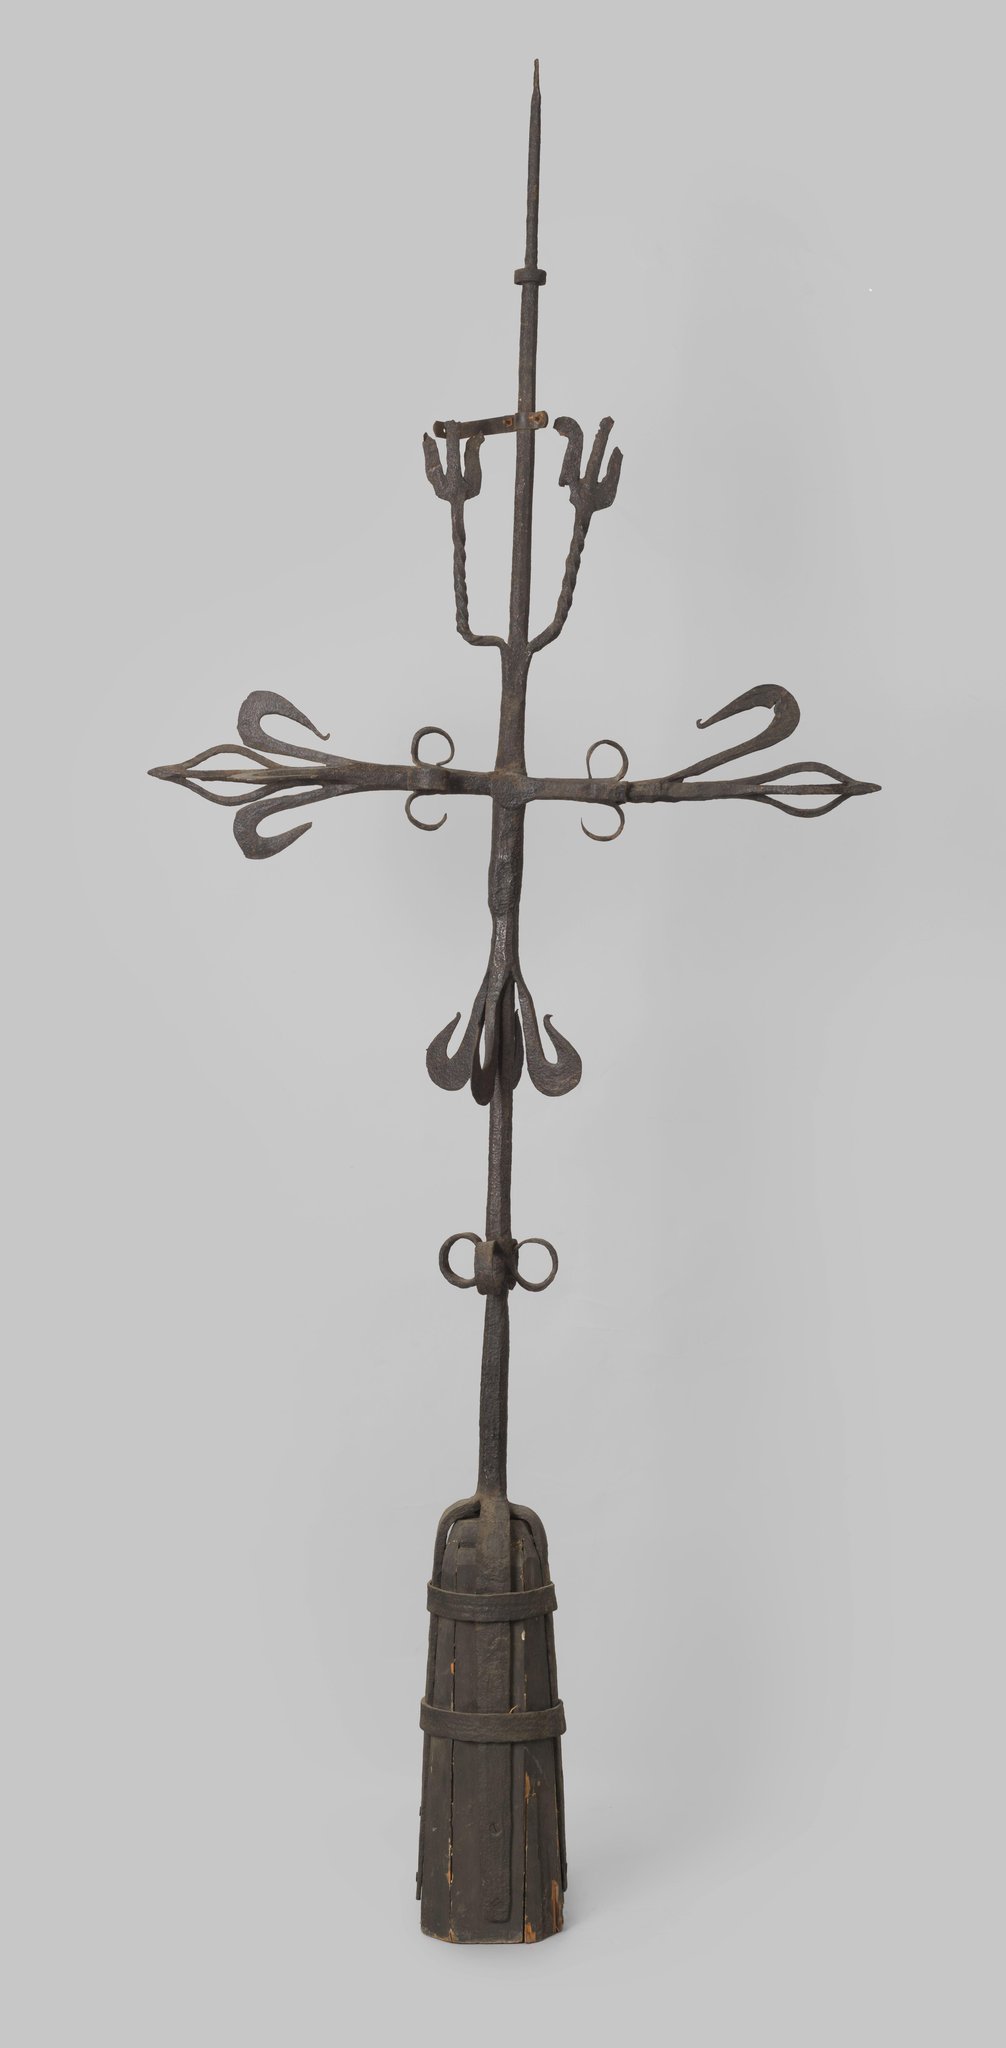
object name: torenkruis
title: Torenkruis, afkomstig van de NH Kerk te Geertruidenberg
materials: iron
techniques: forging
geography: geertruidenberg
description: Een gesmeed ijzeren kruis afkomstig van de toren van de hervormde kerk te Geertruidenberg.